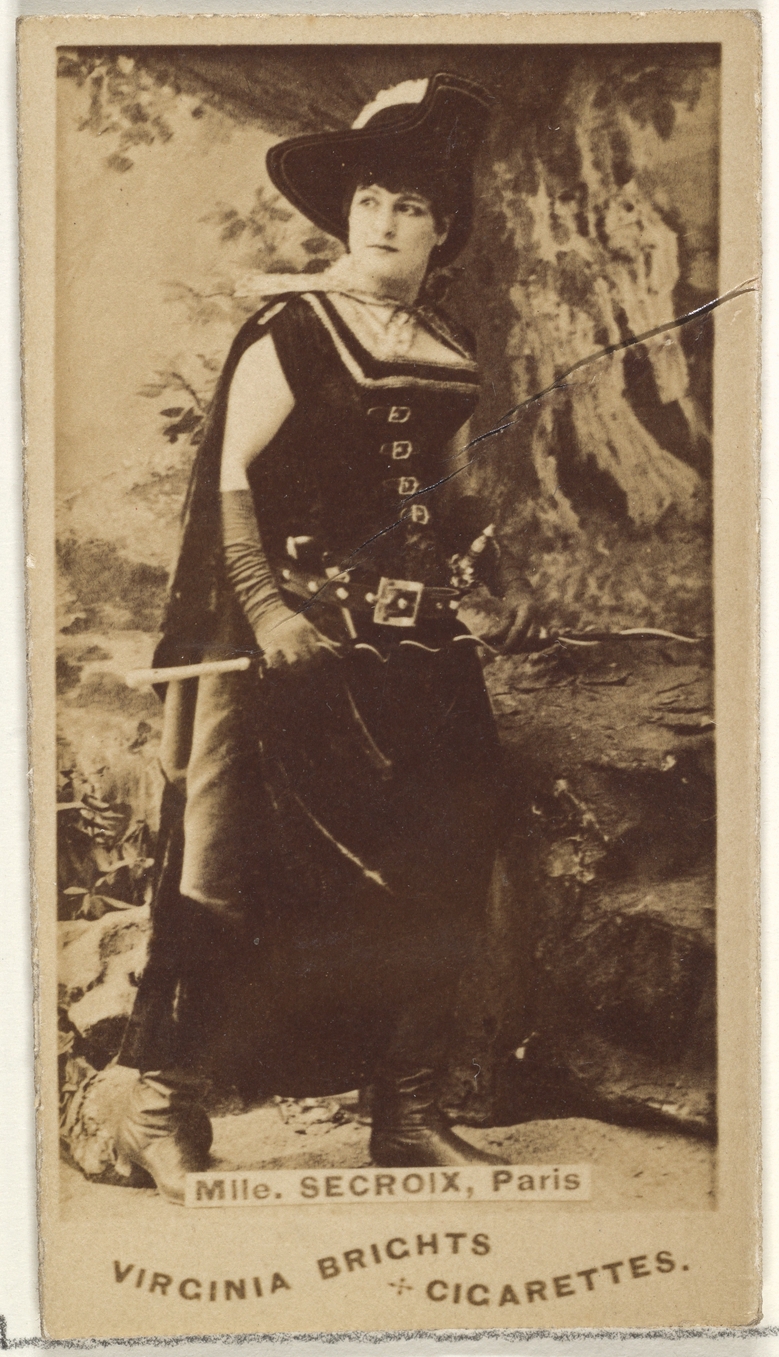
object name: photograph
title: Mlle. Secroix, Paris, from the Actors and Actresses series (N45, Type 1) for Virginia Brights Cigarettes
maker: allen & ginter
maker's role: publisher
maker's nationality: american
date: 1888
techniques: albumen silver print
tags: portraits,women,actresses